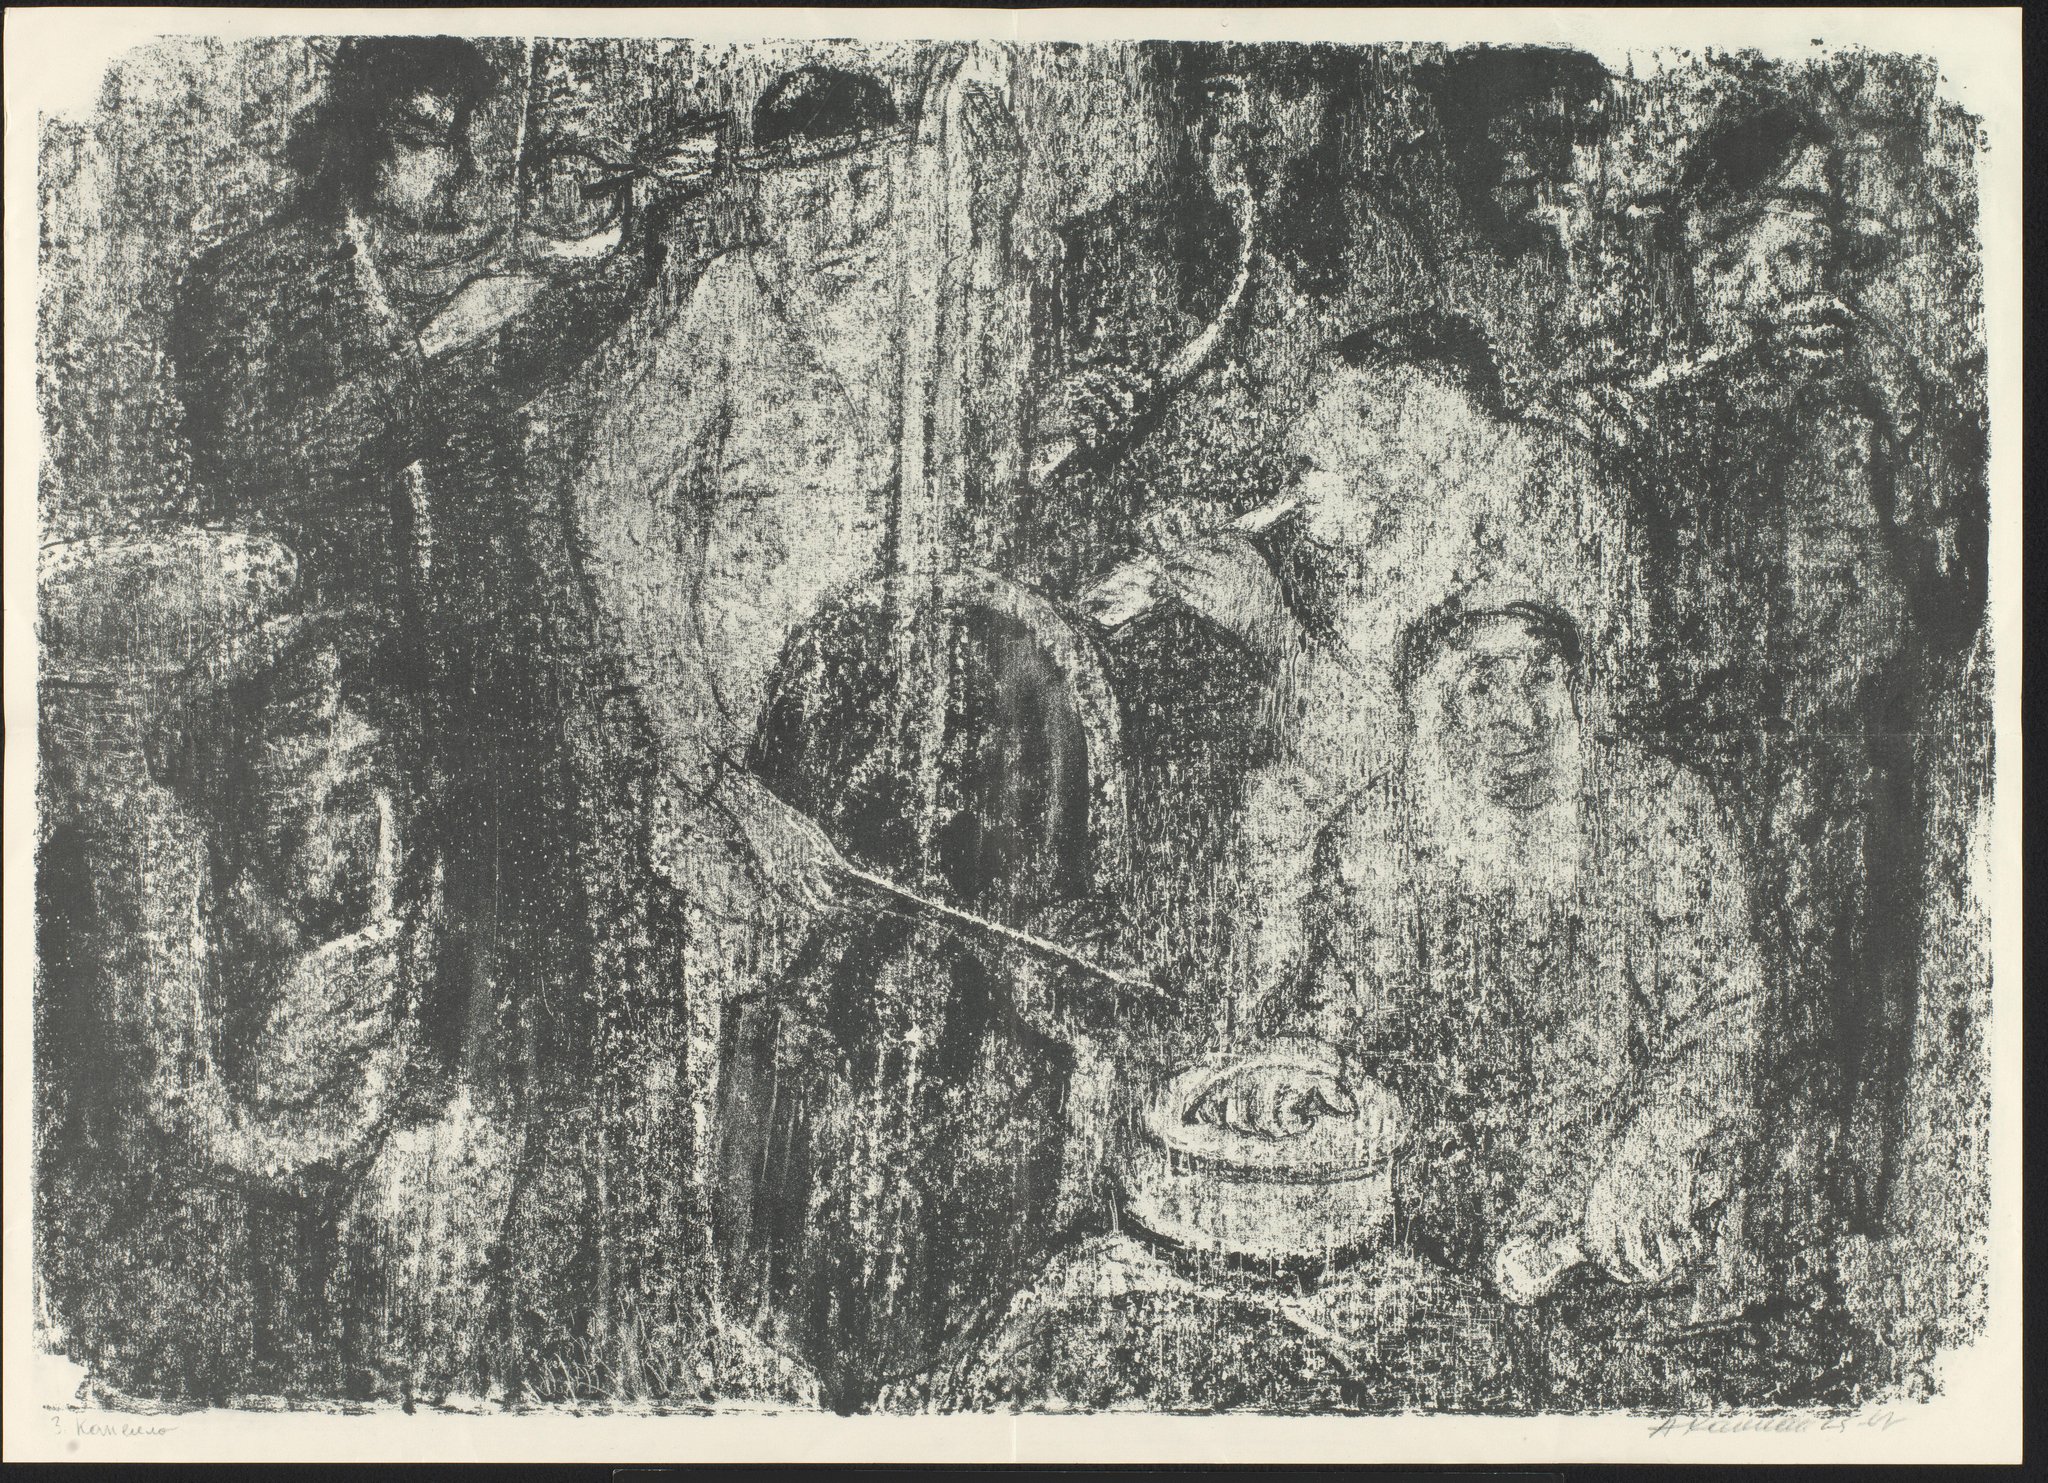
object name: prospectus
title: Kaplan Originalgrafik 'Stempenju'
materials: paper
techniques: photograph, letterpress printing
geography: dresden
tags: fabulous animals (sometimes wrongly called 'grotesques'); 'mostri' (ripa), print, e.g.: engraving, etching, lithograph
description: Gevouwen blad met beschrijvende tekst voor de publicatie, met daarin een tweemaal gevouwen blad. Op het tweede blad een reproductie van een van de dertig litho's die Kaplan maakte ter illustratie van de roman 'Stempenju' door Sjolem Alejchem. Deze prent vertoont een klezmer muziekgroep. Onder de prent zijn zowel handtekening als de titel fotomechanisch gereproduceerd. Originele titel onleesbaar.